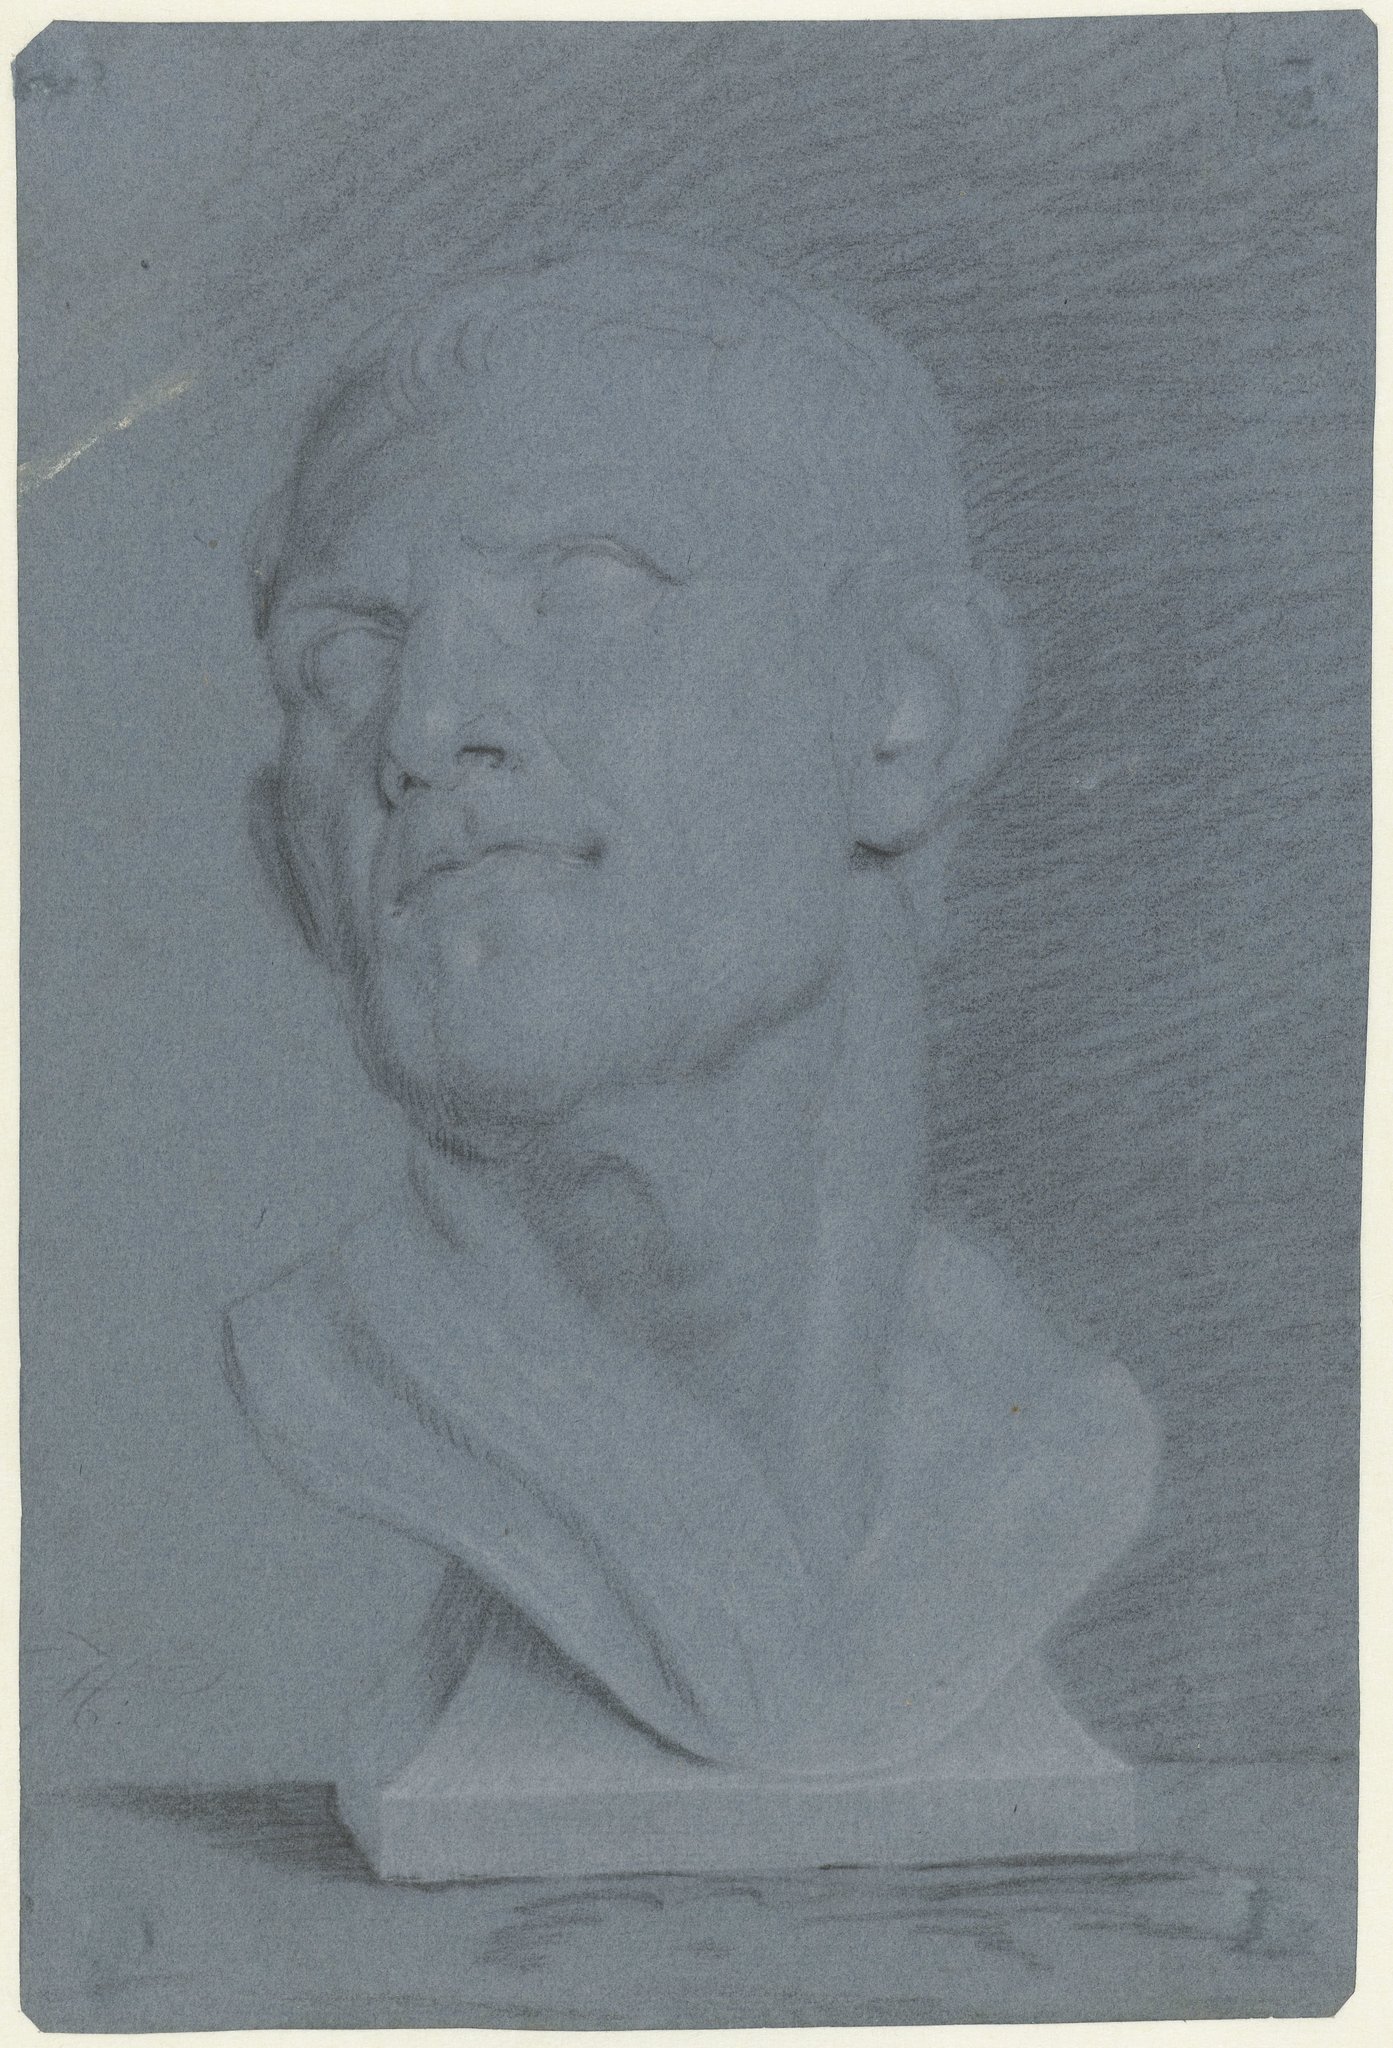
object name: drawing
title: Schets van een opziende man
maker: jordanus hoorn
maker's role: draughtsman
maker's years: 1753-1833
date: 1773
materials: chalk, paper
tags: piece of sculpture, reproduction of a piece of sculpture, anonymous historical person portrayed alone (+ head (and shoulders) (portrait))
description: Schets naar een pleisterbuste van een opziende man.